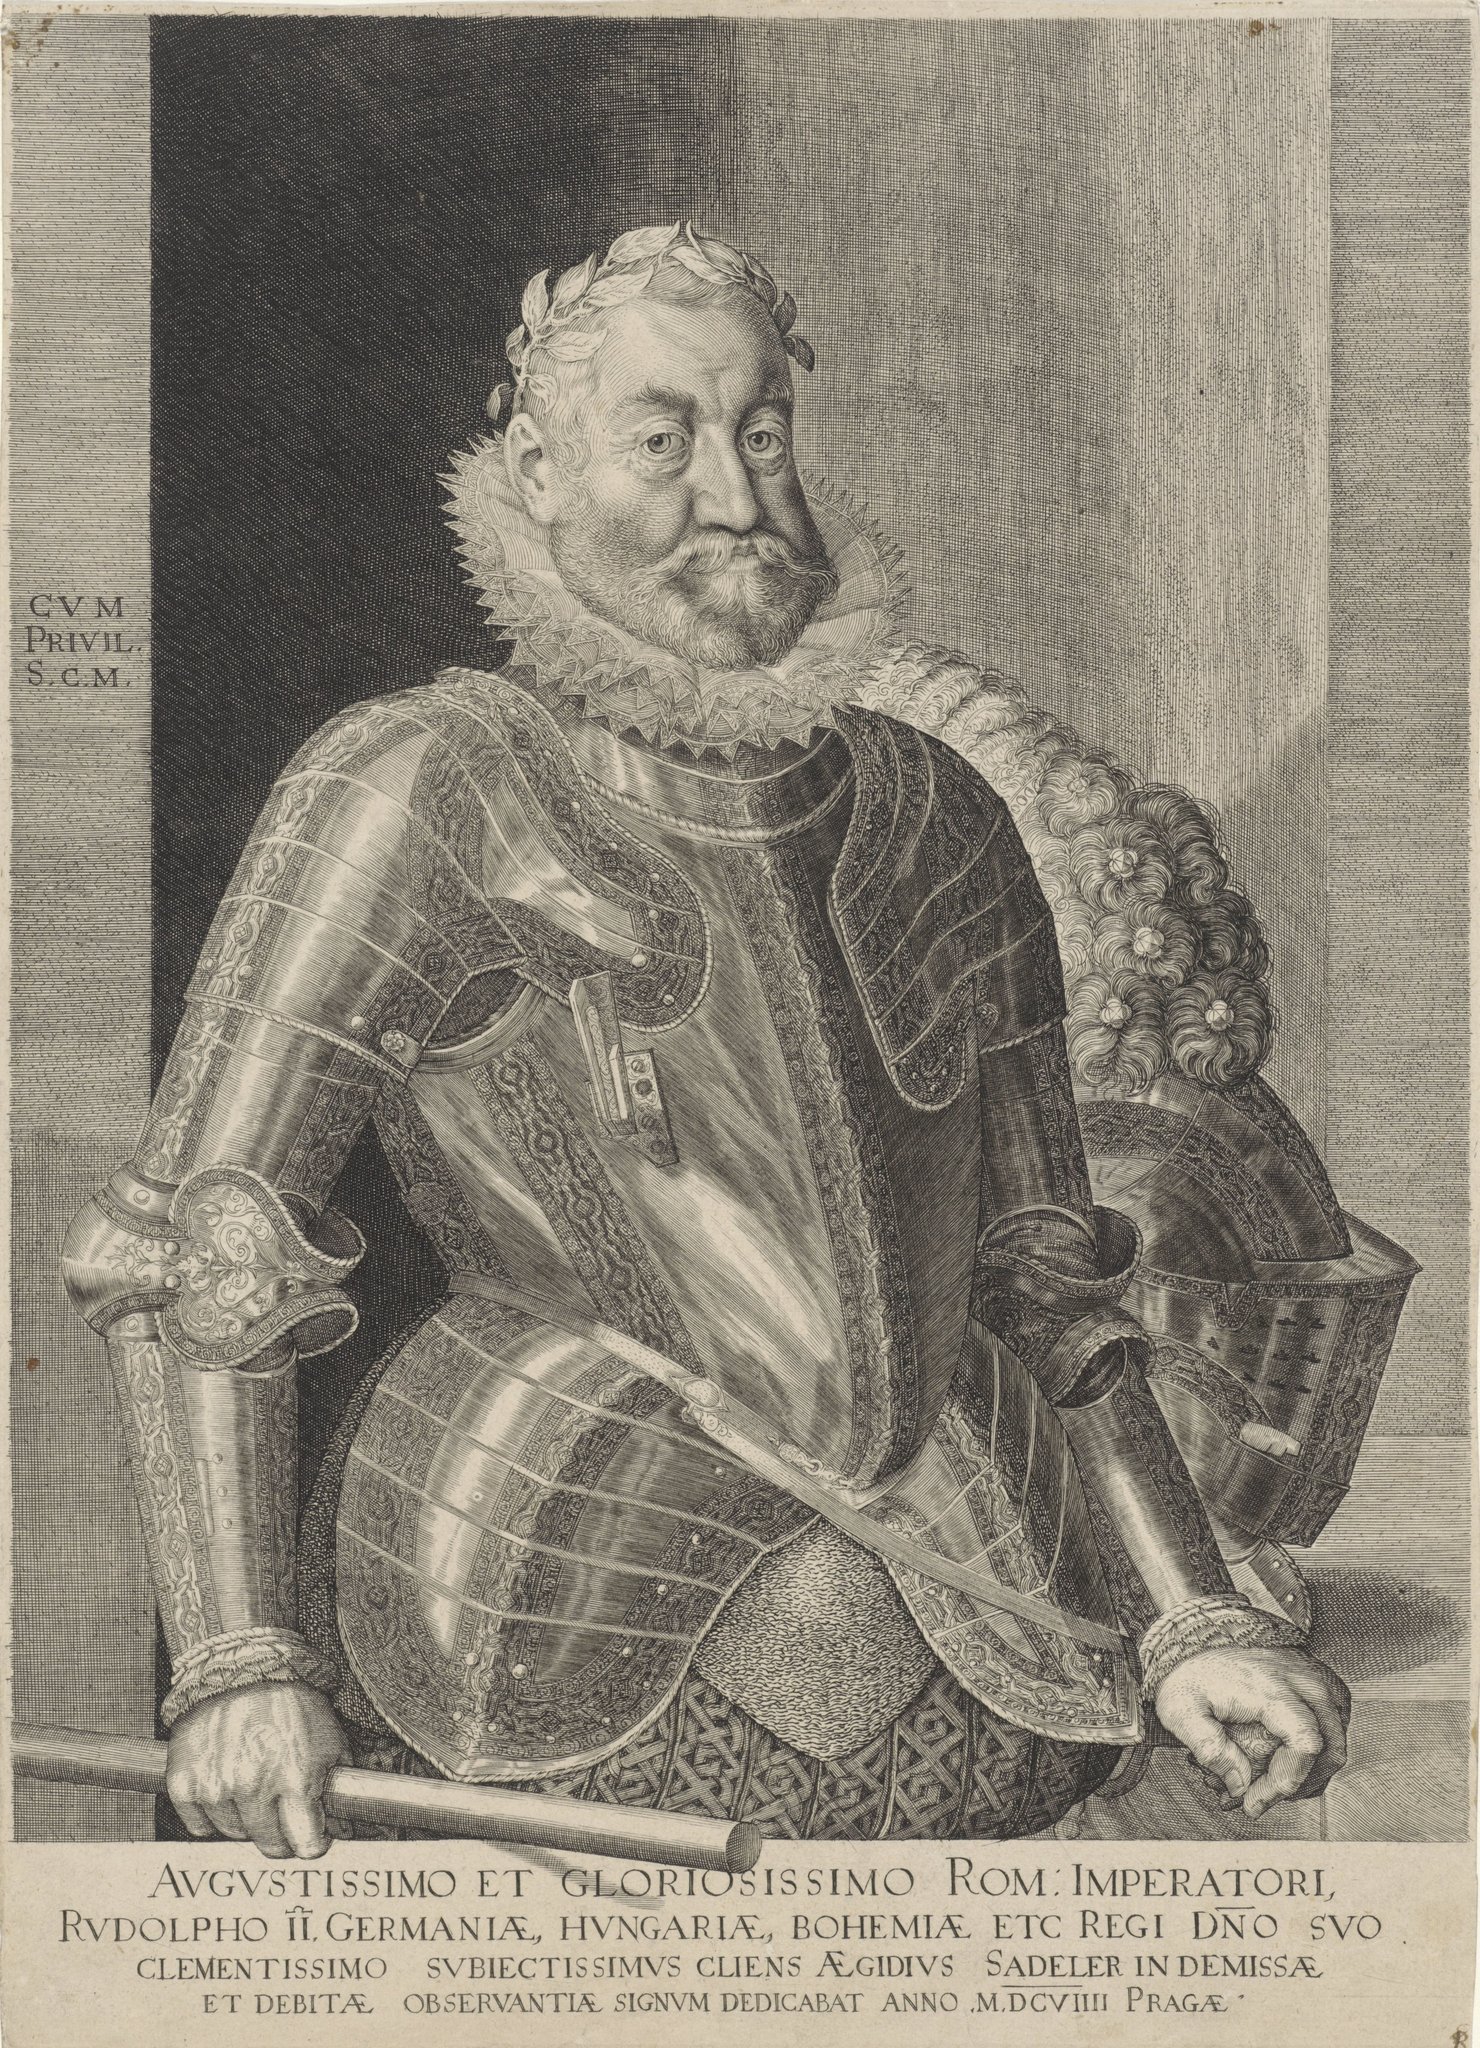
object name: print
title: Portret van keizer Rudolf II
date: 1609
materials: paper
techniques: engraving, etching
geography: prague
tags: rudolf ii van habsburg (duits keizer), armour, hacking and thrusting weapons: sword, baton of general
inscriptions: collector's mark: Lugt 240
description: Rudolf II, keizer van het Heilig Roomse Rijk in harnas, staand bij tafel. In zijn rechterhand een staf, in zijn linkerhand een zwaard. Met een Latijnse opdracht aan de keizer onder het portret.